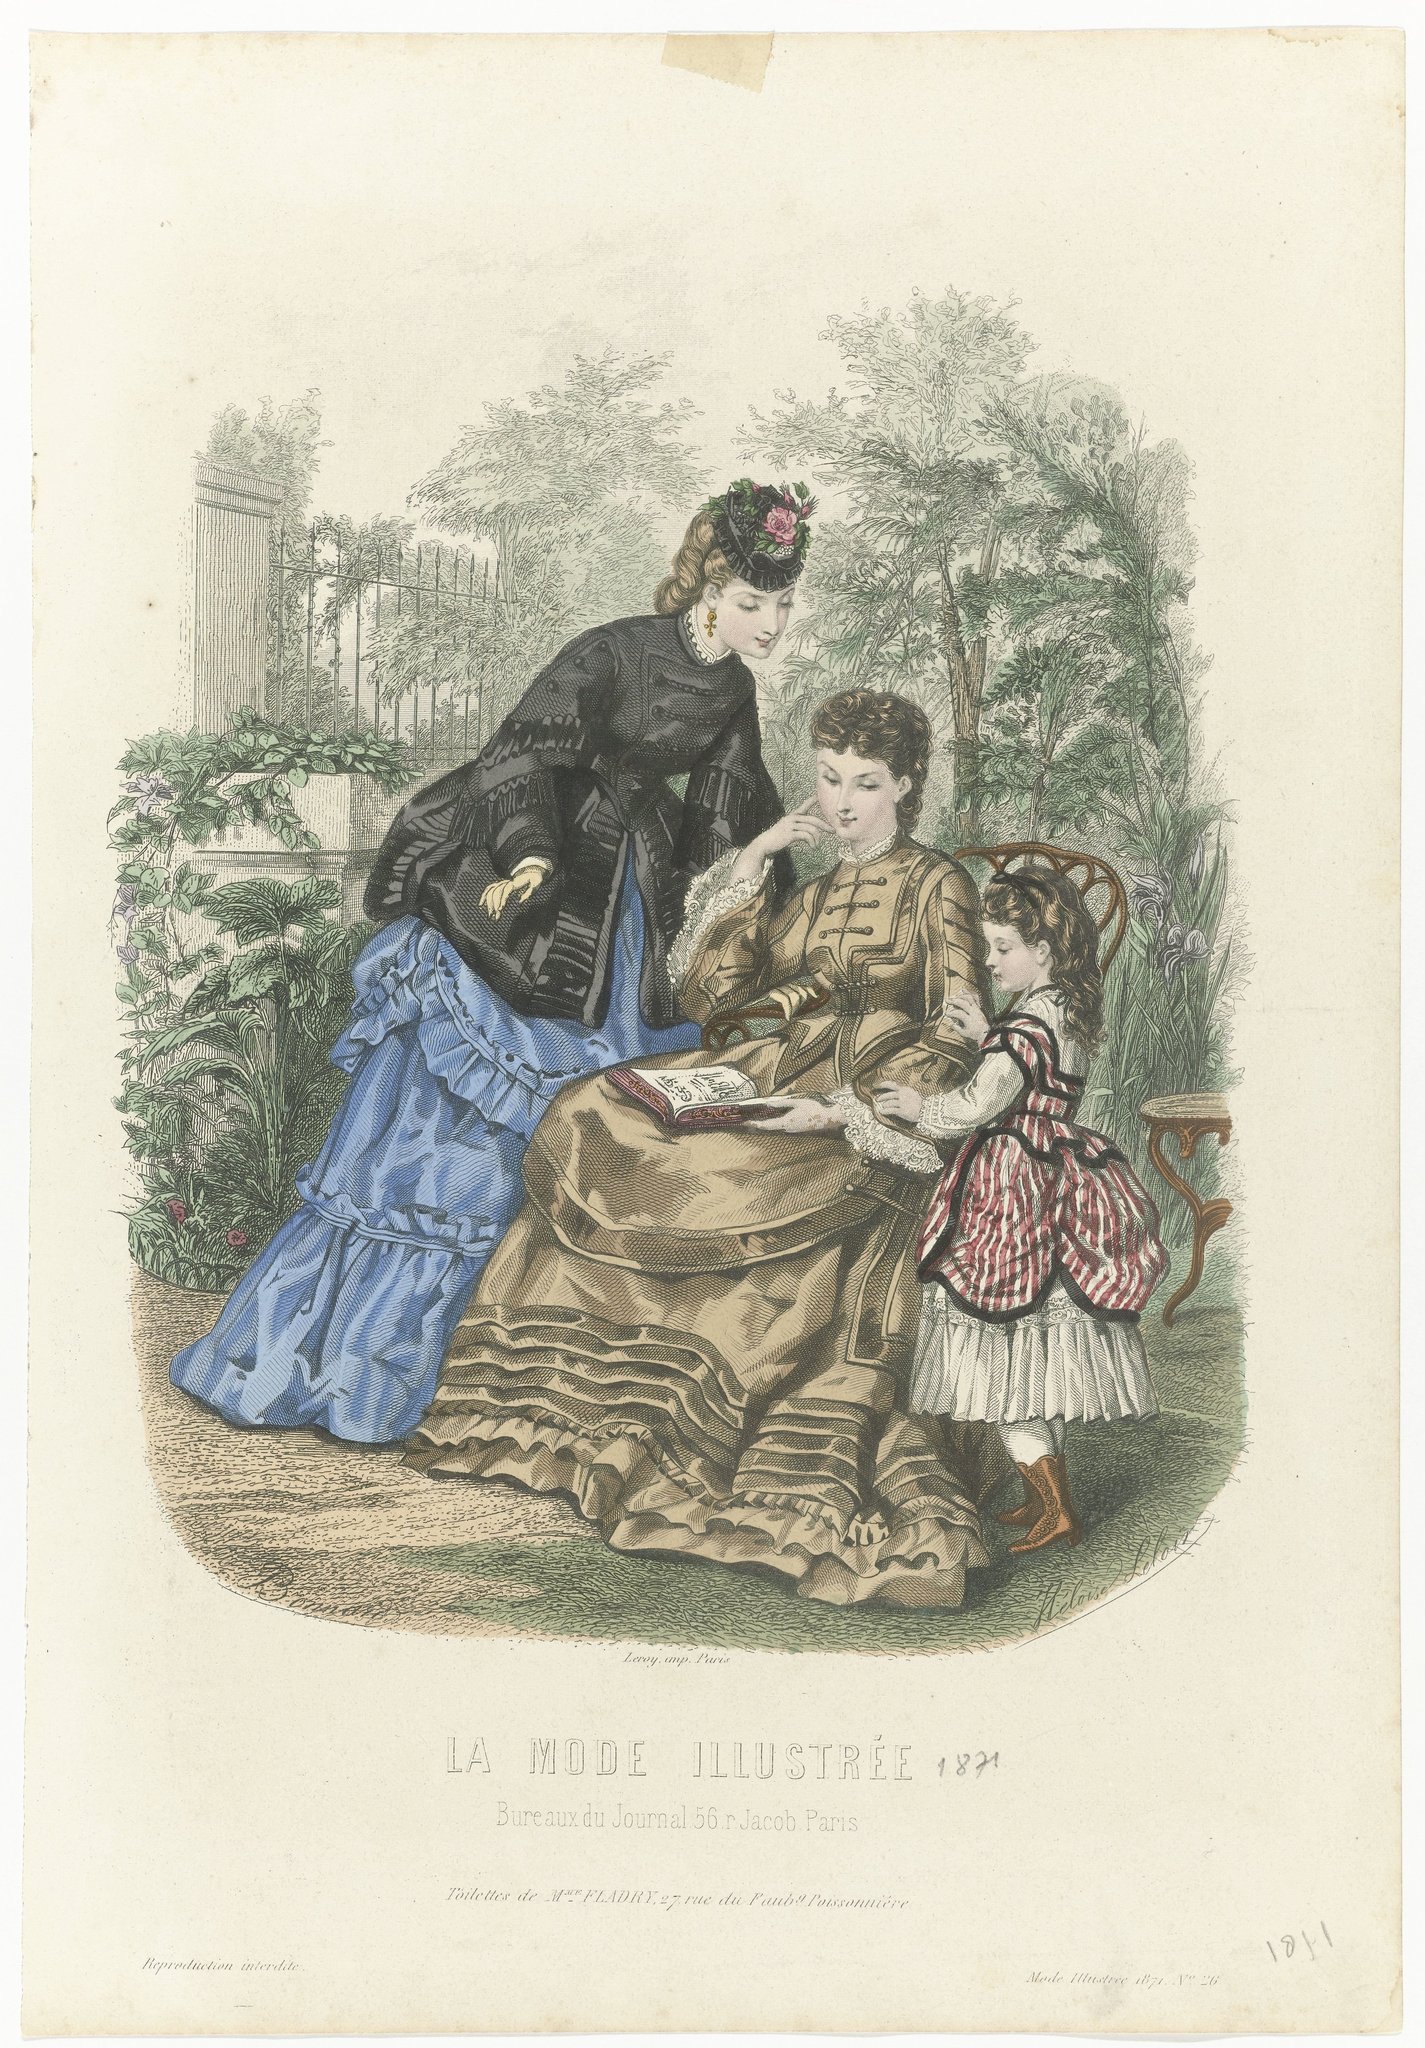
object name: fashion print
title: La Mode Illustrée, 1871, No. 26: Toilettes de Mme Fladry (...)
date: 1871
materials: paper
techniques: engraving, hand coloring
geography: paris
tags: ear-rings (+ women's clothes), boots (+ girls' clothes), coat (+ women's clothes), head-gear (+ women's clothes), fashion plates, dress, gown (+ women's clothes), book - mm - book open, dress, gown (+ girls' clothes)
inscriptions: address: ‘Bureaux du Journal, 56, r. Jacob. Paris’, caption: ‘Toilettes de Mme Fladry, 27. rue du Faubg Poissonnière’, title: ‘La Mode Illustrée’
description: Twee vrouwen en een meisje in een tuin, gekleed in japonnen van Fladry. Prent uit het modetijdschrift La Mode Illustrée (1860-1937).